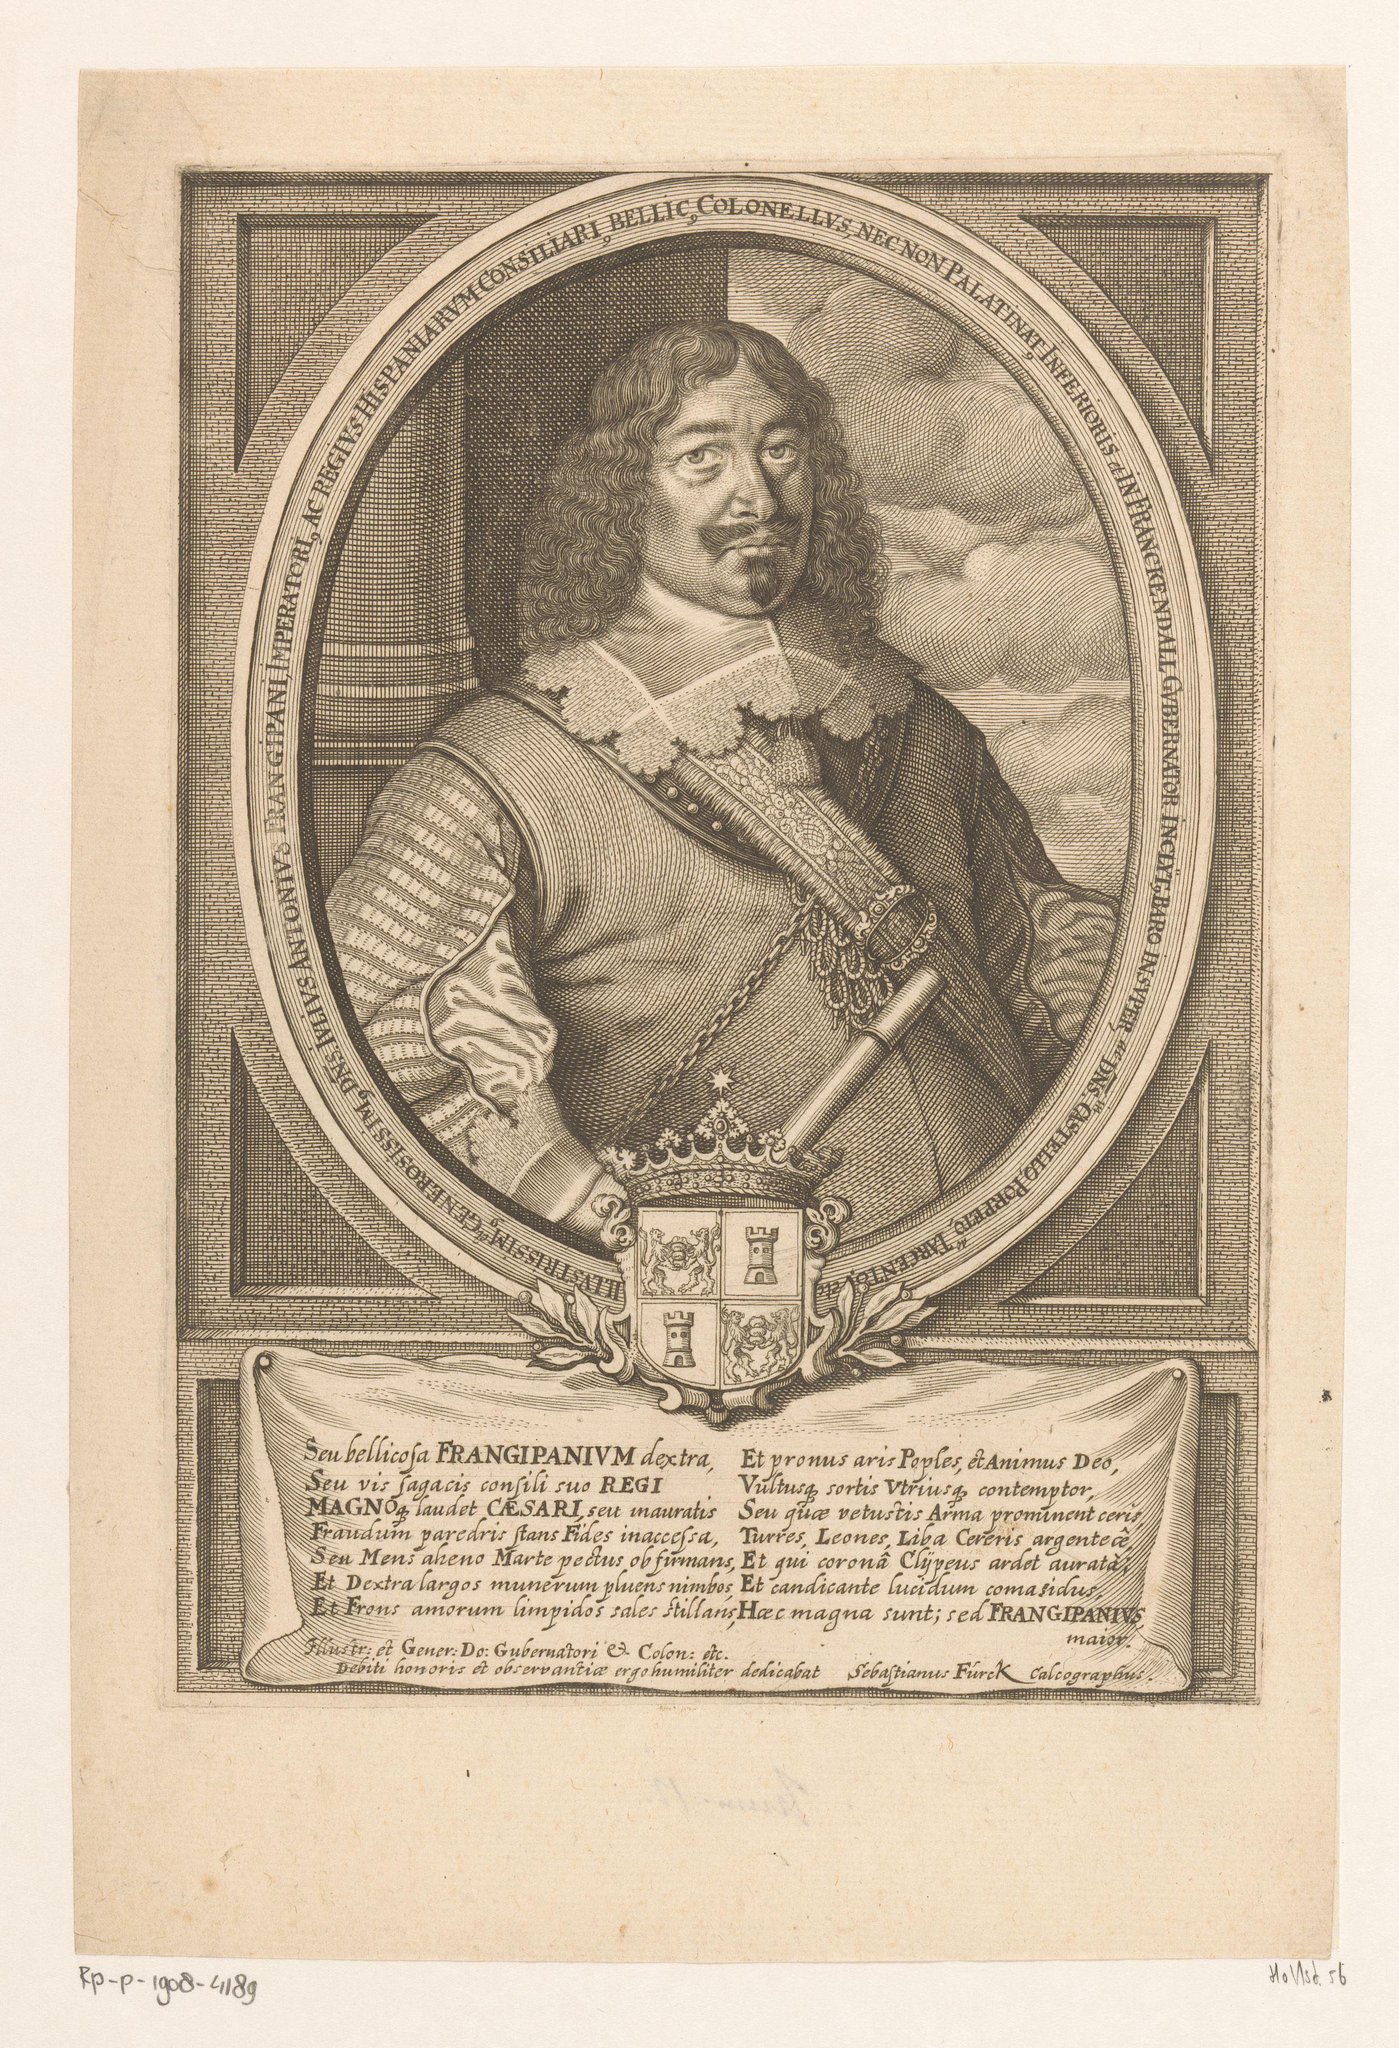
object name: print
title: Portret van Antonius Frangipani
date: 1616-1655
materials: paper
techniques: engraving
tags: ornament ~ medallion, historical persons, baton of general, armorial bearing, heraldry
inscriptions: collector's mark: Lugt 2228